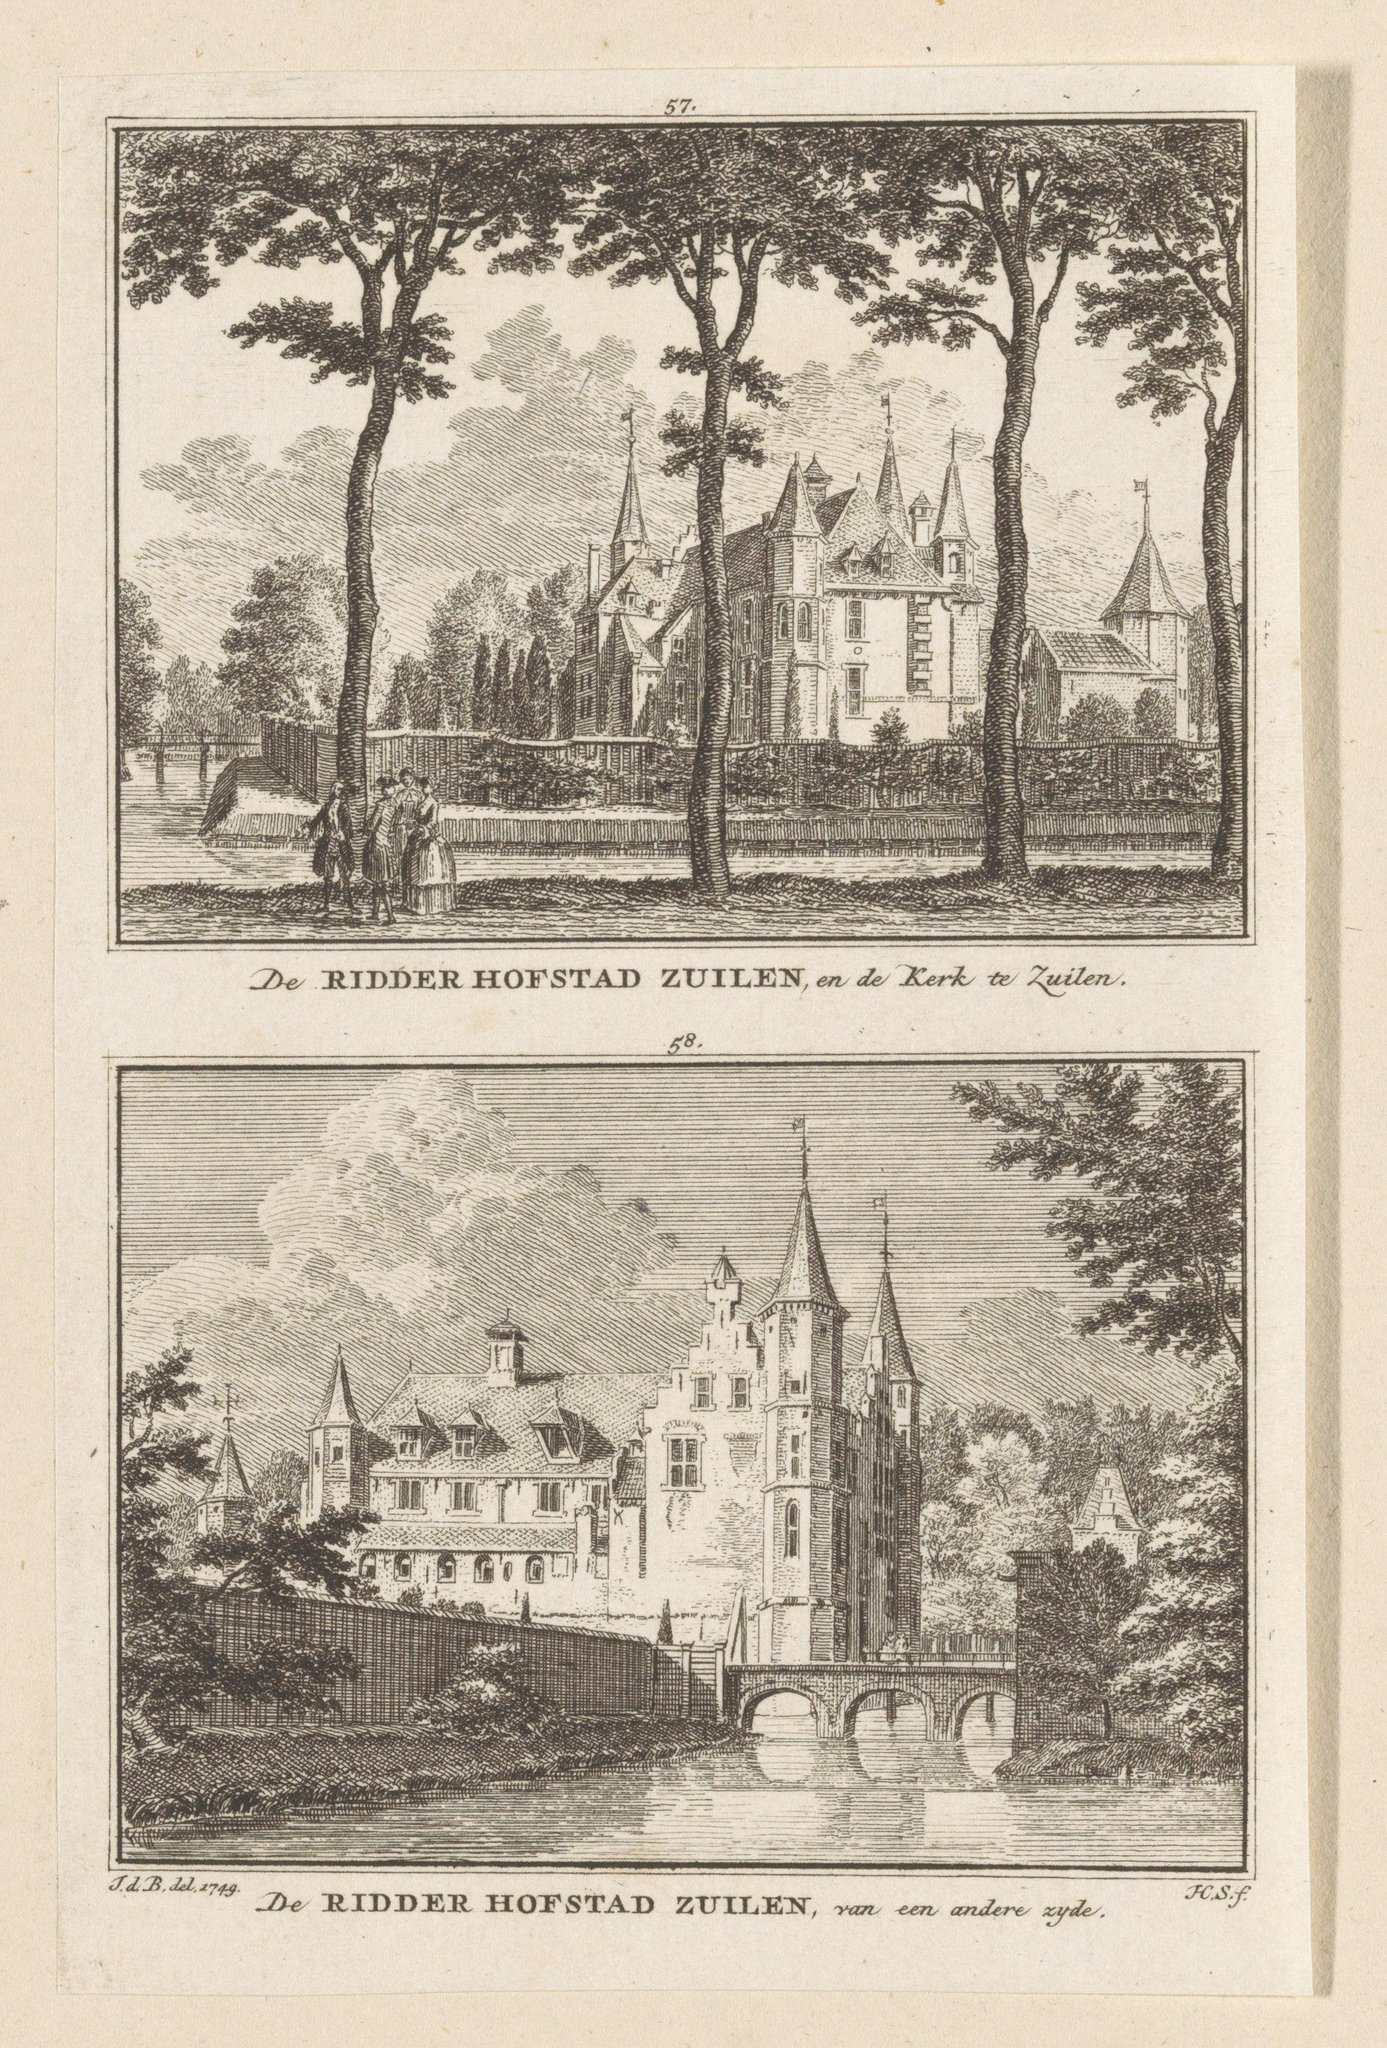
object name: book illustration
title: De ridder hofstad Zuilen, van een andere zyde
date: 1773-1792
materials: paper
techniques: engraving, etching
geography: haarlem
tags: castle, church (exterior), gate, entrance, bridge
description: Prent ook gebruikt in: Het verheerlykt Nederland of kabinet van hedendaagsche gezigten van steden, dorpen (…). 9 delen. Amsterdam: Isaak Tirion en weduwe Isaak Tirion, 1745-1774, dl. 7, 8 of 9 (weduwe Isaak Tirion, 1773-1774), ill. 57 en 58. Of in: Nederlandsche tafereelen; of eene keurige verzameling van negen honderd fraaije gezigten van steden, dorpen, sloten, oudheden (….). 9 delen. Amsterdam: Jan de Groot, 1792, dl. 7, 8 of 9, ill. 57 en 58. Uit welke druk het huidige exemplaar precies komt is niet na te gaan.